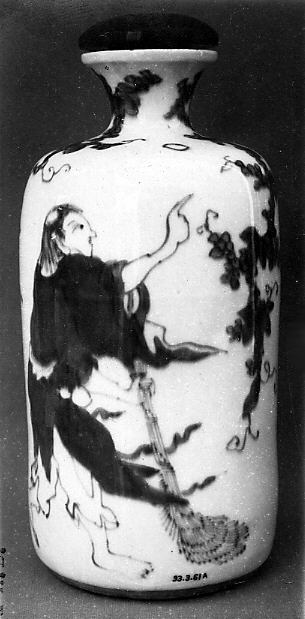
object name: bottle with cover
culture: japanese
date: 1630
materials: glaze, porcelain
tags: men